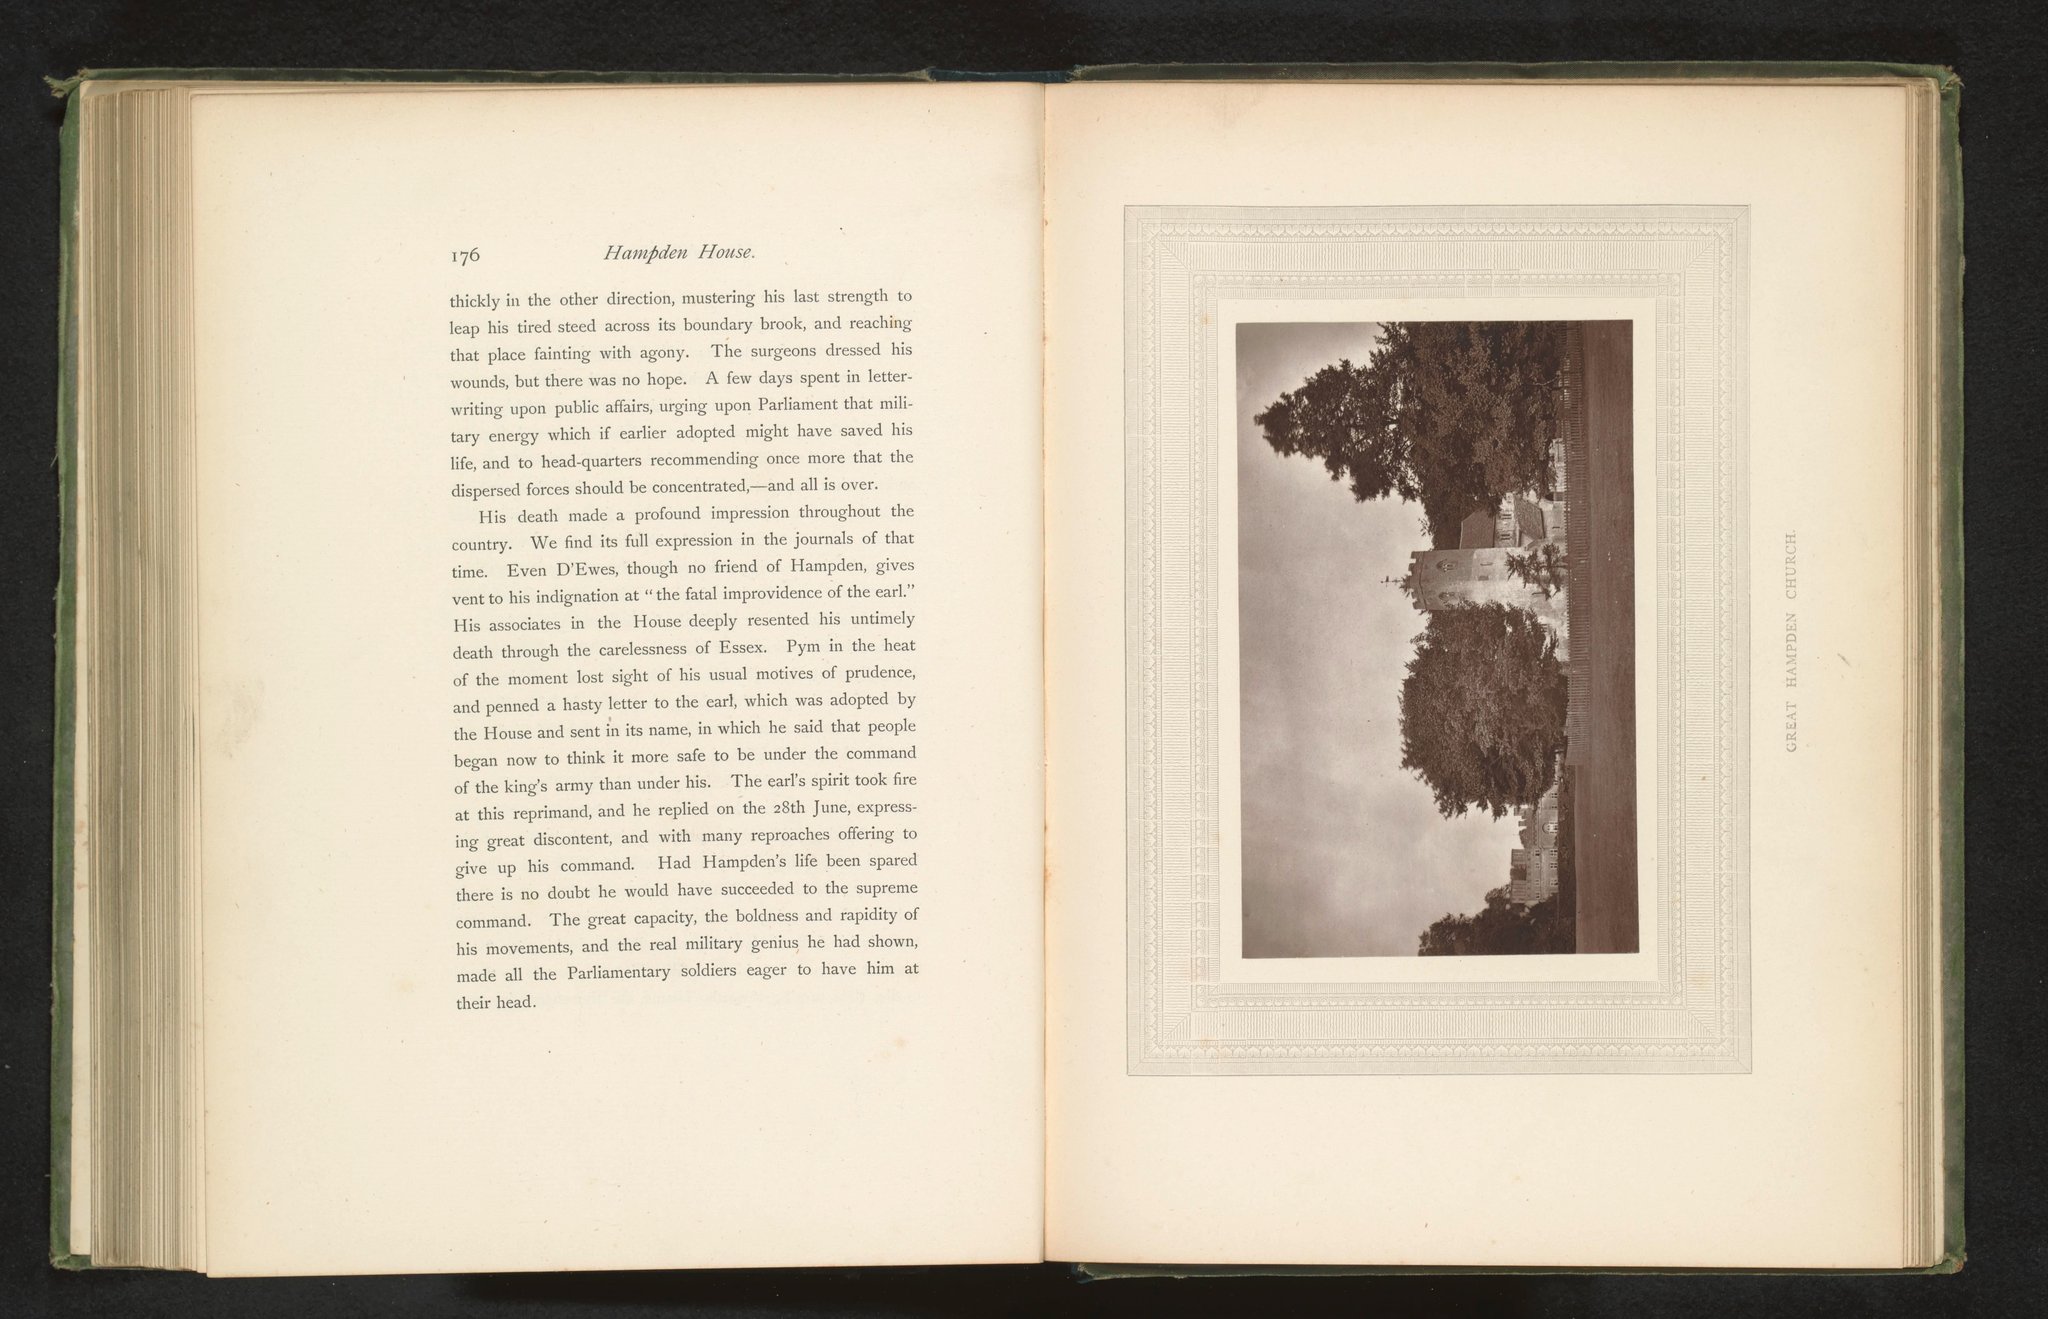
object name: page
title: Gezicht op een kerk bij Hampden House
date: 1866-1876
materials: paper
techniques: woodburytype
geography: great and little hampden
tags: church (exterior), country-house